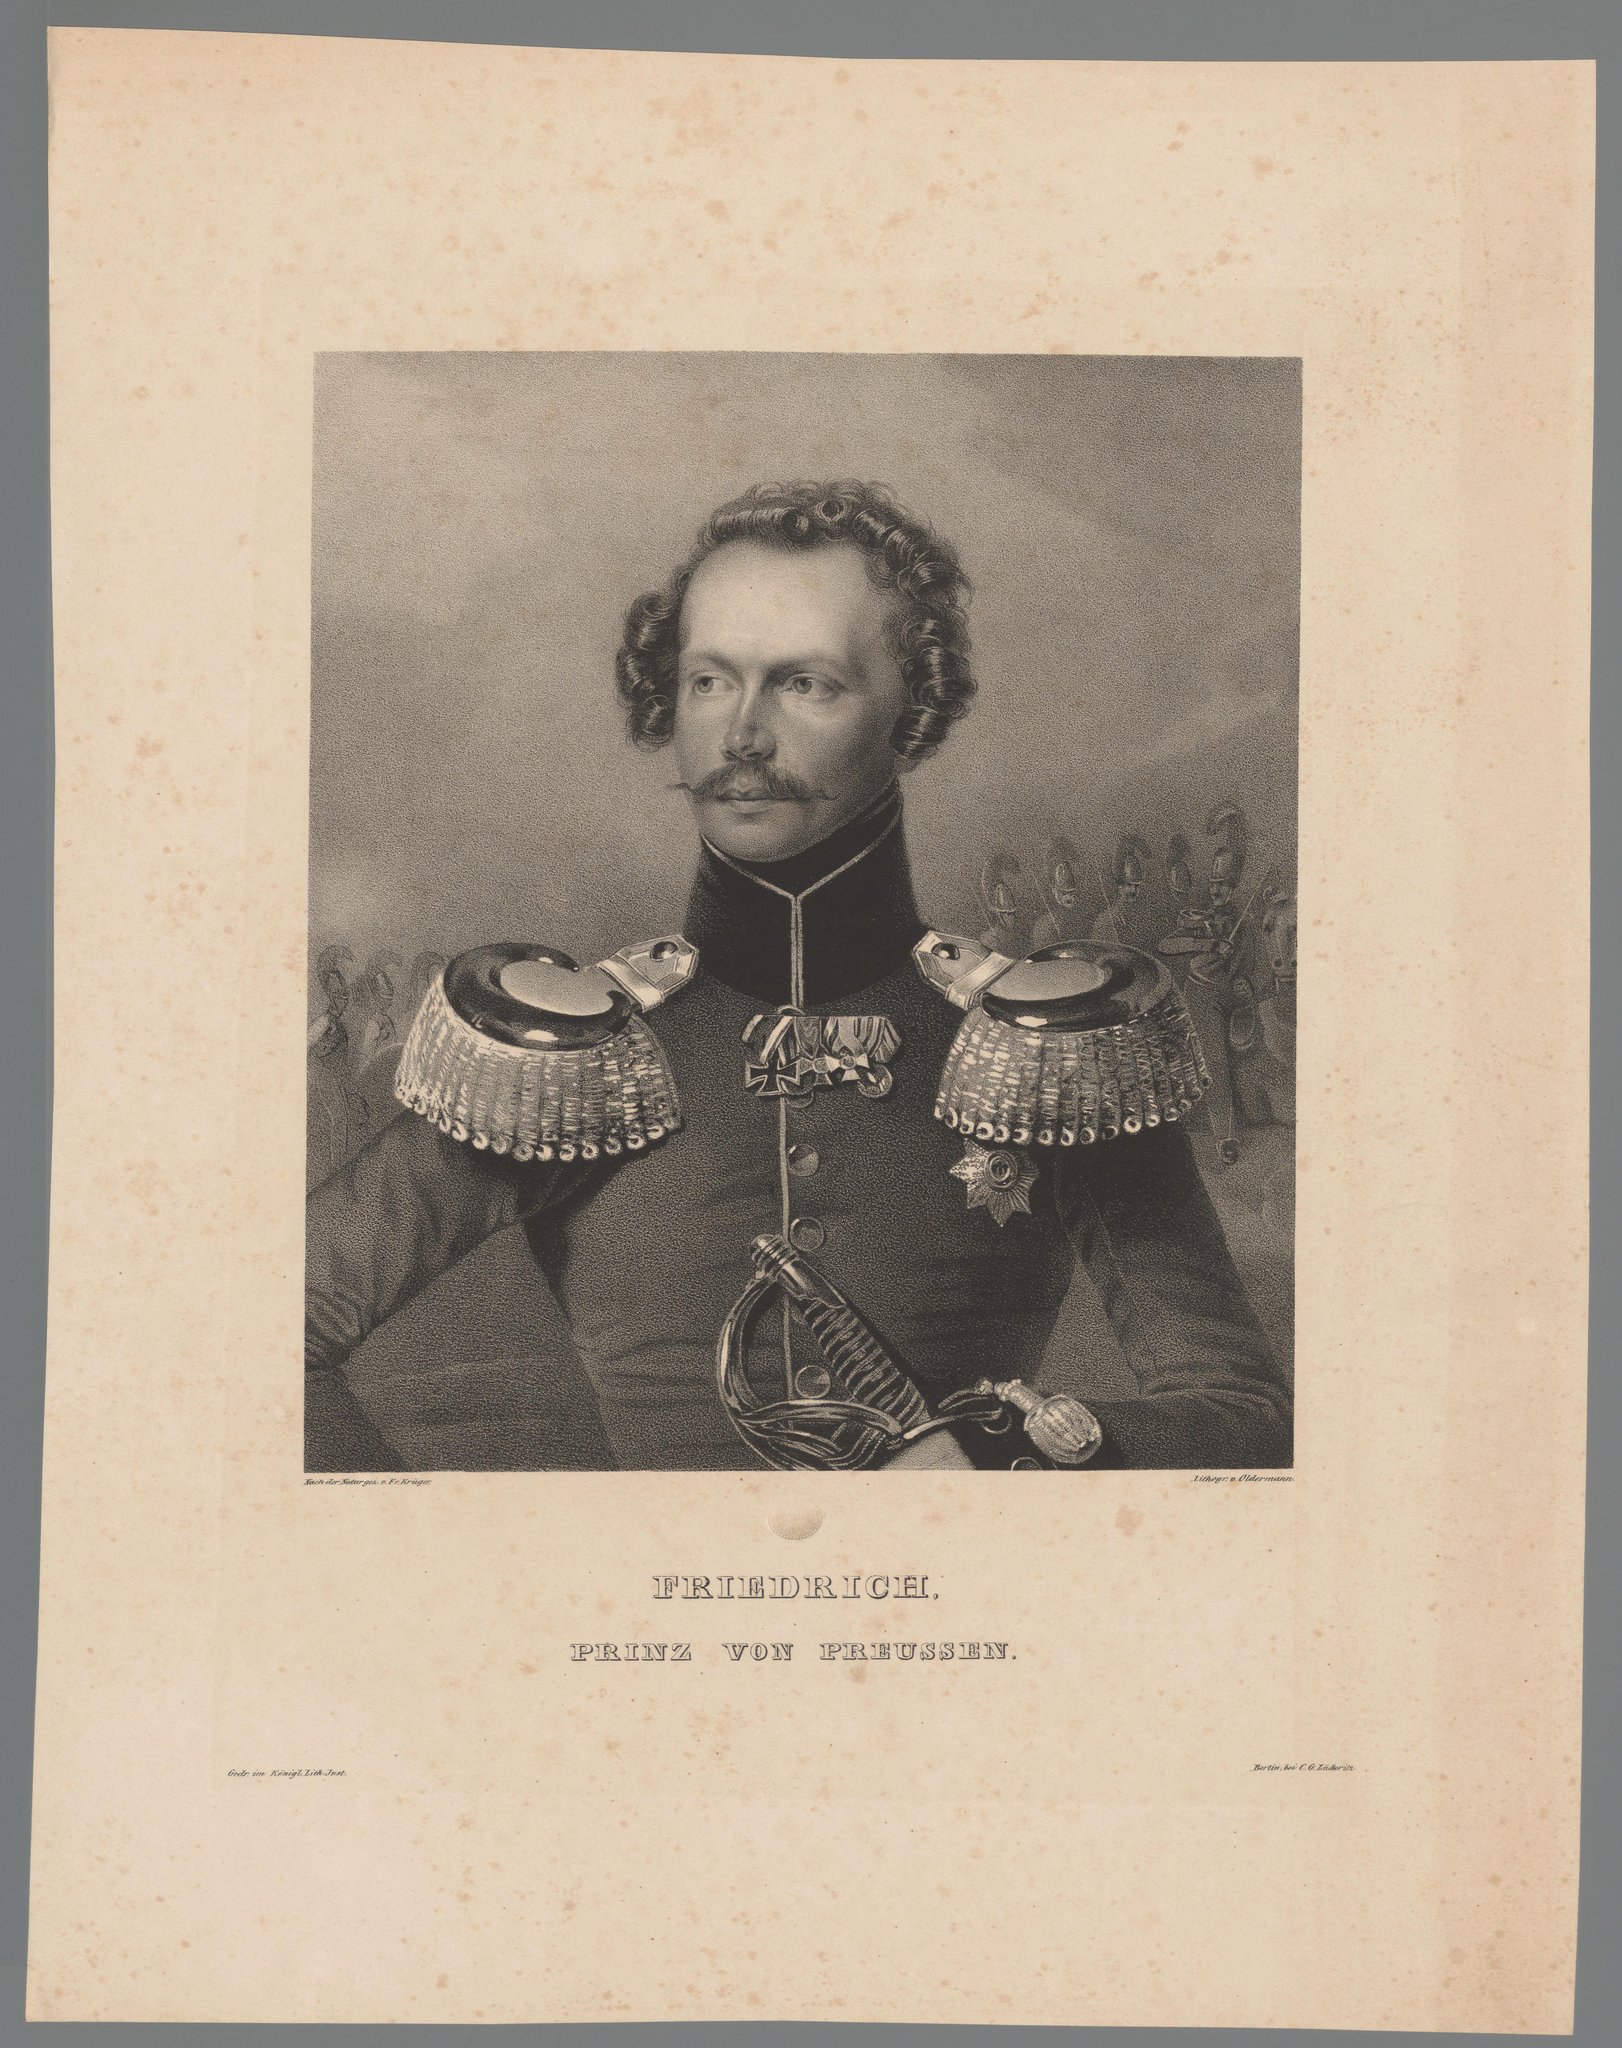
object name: print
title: Portret van Frederik, prins van Pruisen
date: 1812-1874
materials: paper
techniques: lithograph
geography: berlin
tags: berlin, adult man, historical persons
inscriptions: check stamp: ‘C.G. Lüderitz’, collector's mark: Lugt 2228